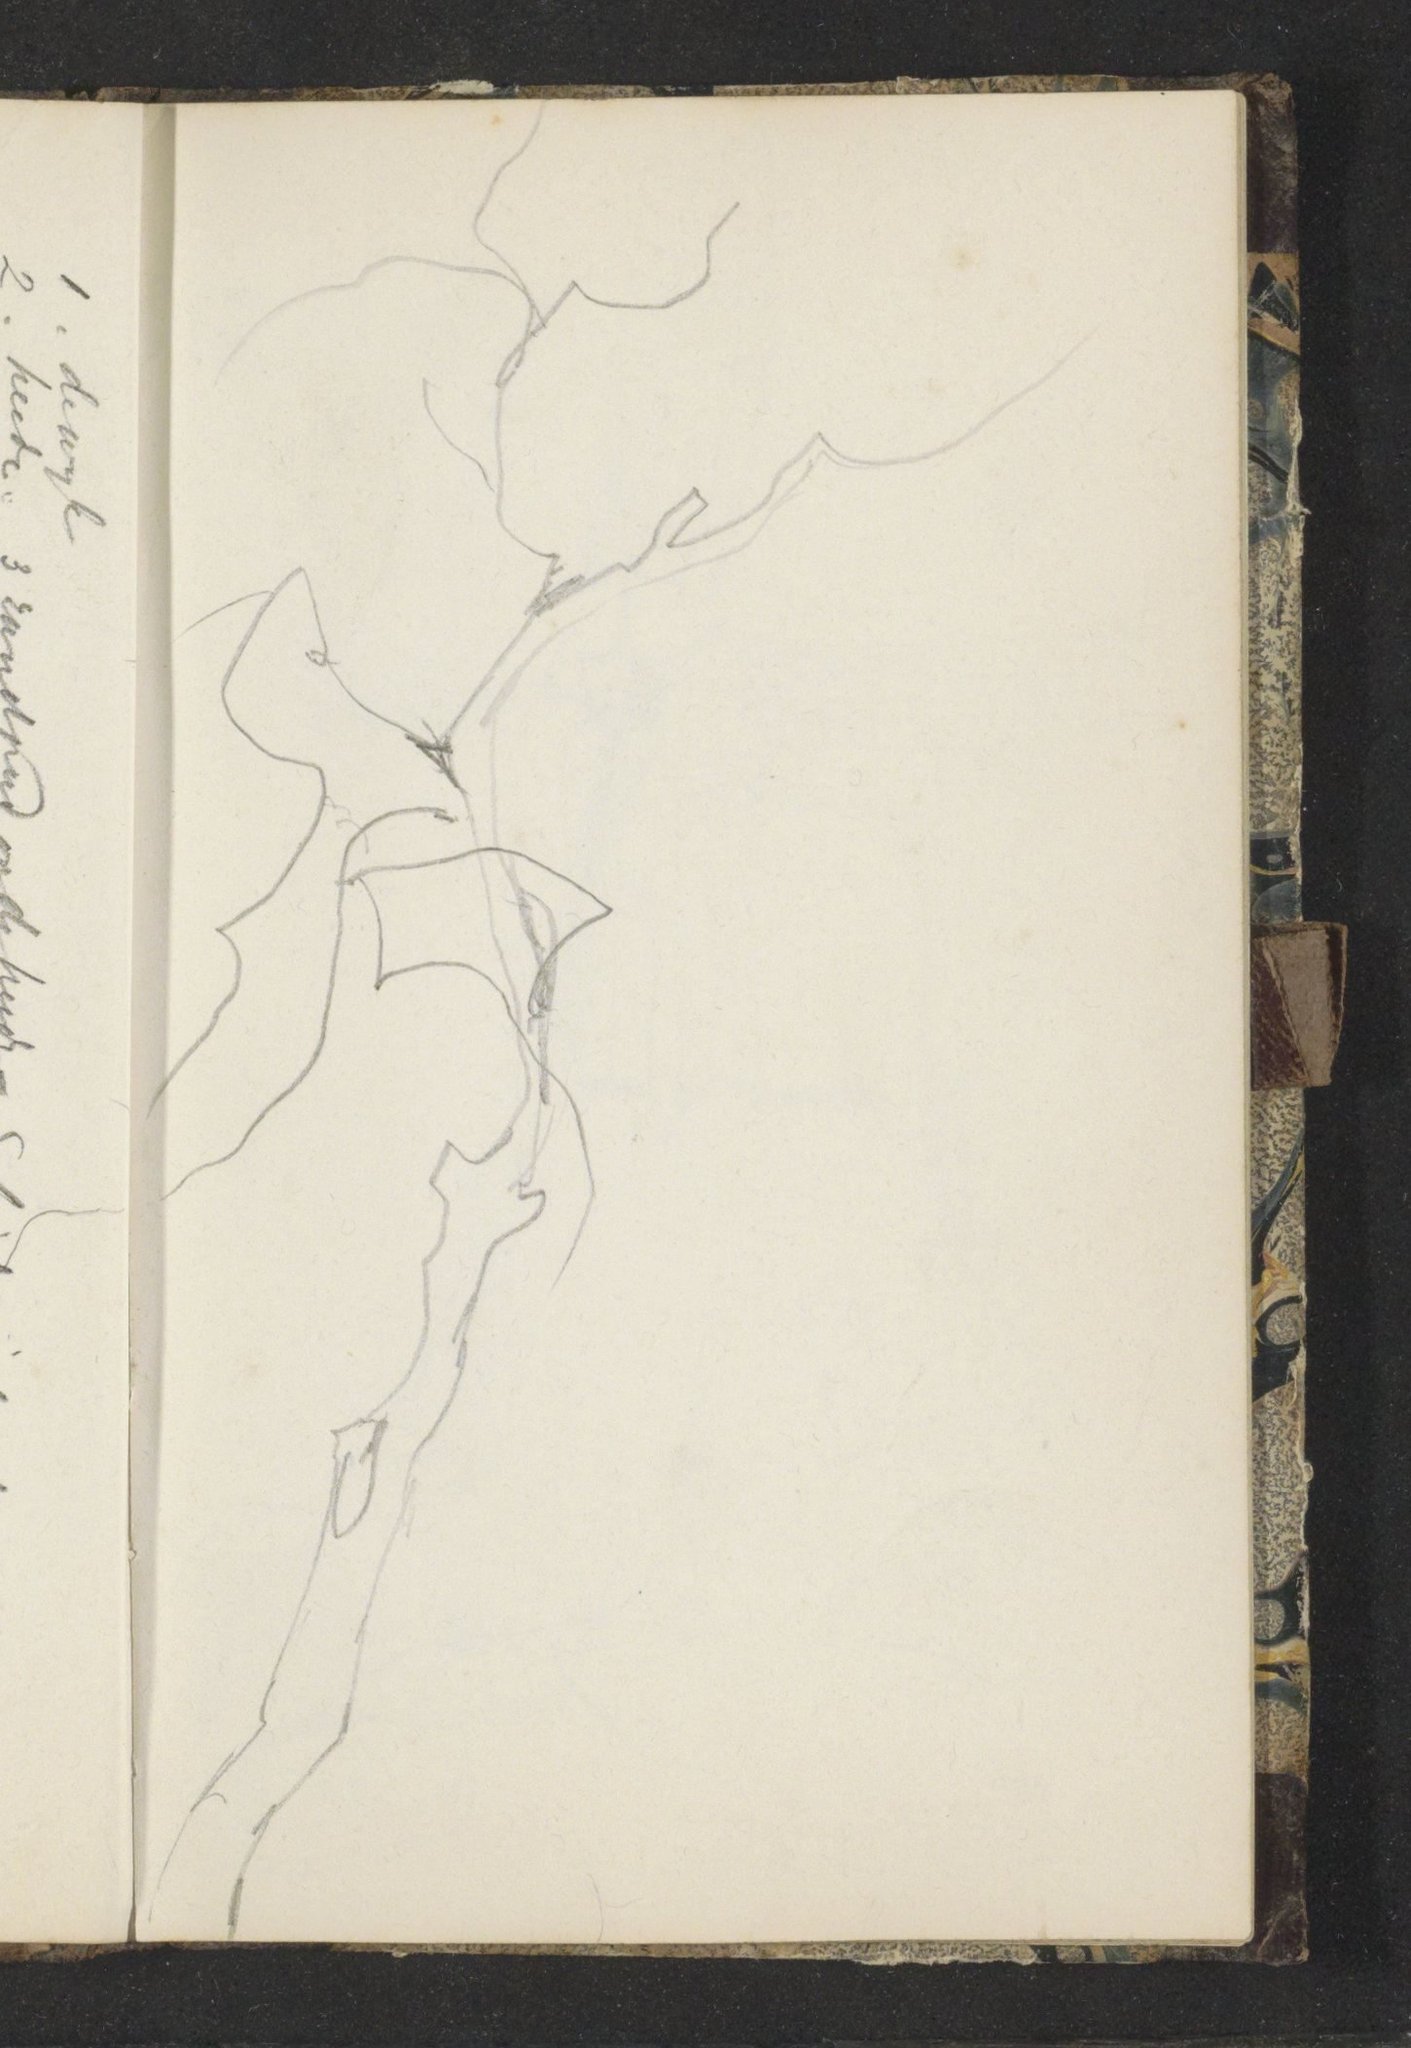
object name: sketchbook leaf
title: Boom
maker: Anonymous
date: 1802-1874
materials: paper, pencil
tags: trees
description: Blad 9 recto uit een schetsboek met 19 bladen.